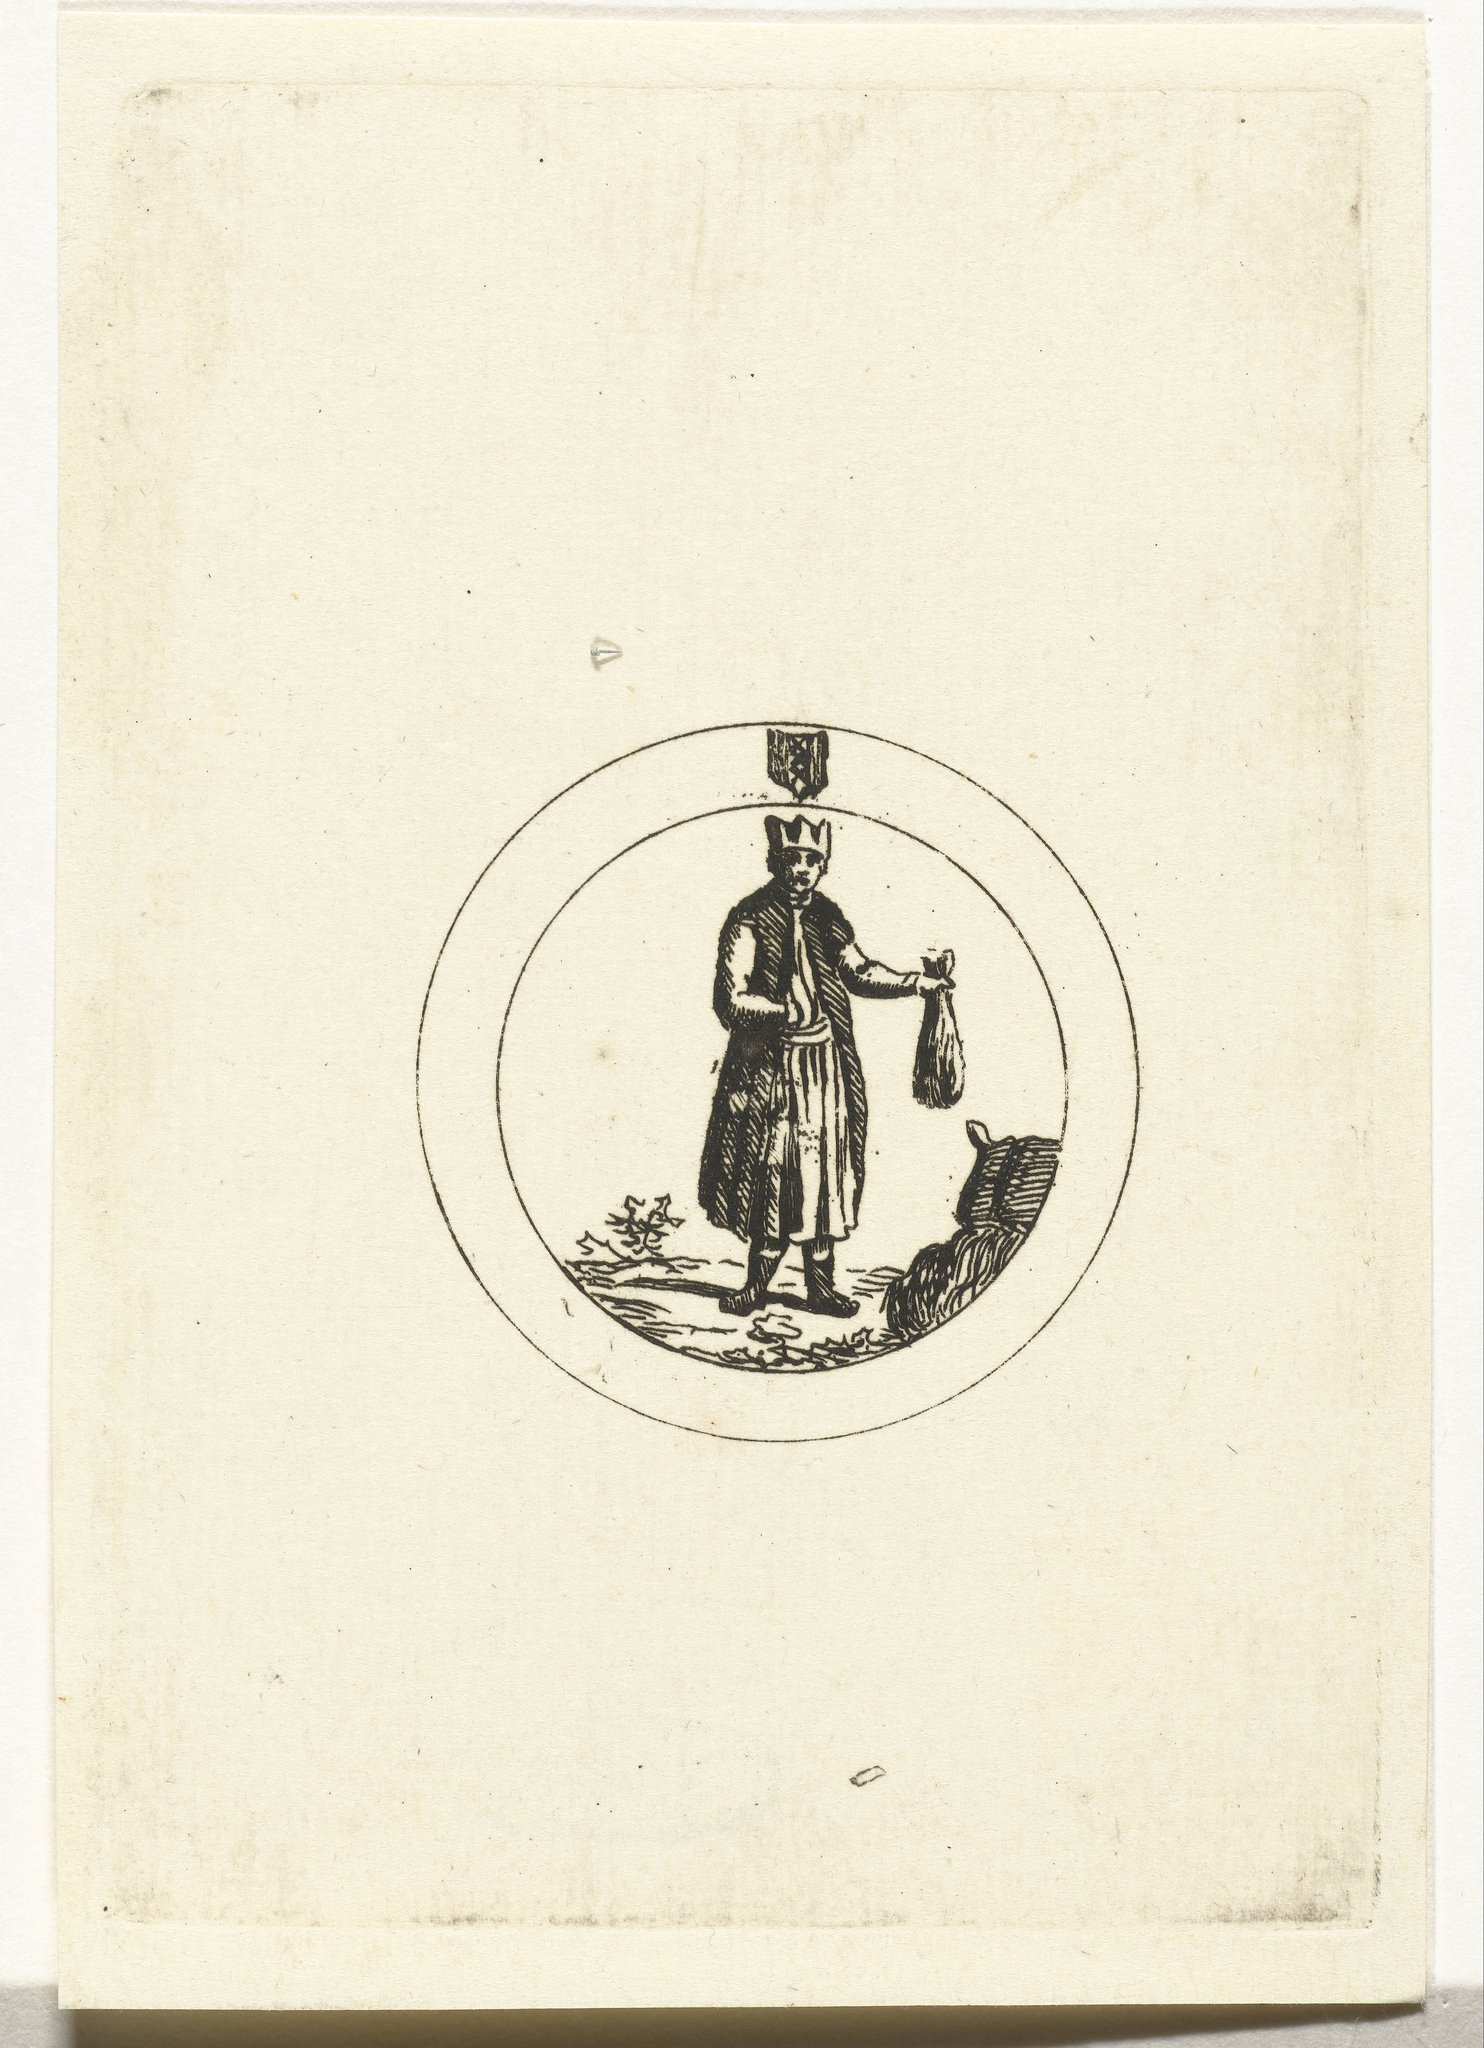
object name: print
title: Staande figuur in een cirkel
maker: anthonie van den bos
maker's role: draughtsman, print maker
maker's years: 1763-1838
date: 1778-1838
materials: paper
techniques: etching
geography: netherlands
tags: trade mark, trade token, trade sign, trade card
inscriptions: collector's mark: Lugt 2228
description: Koopmansmerk(?): een staande figuur met kroon op het hoofd, de rechterhand in de borst gestoken, in de andere hand houdt hij een tabaksblad (?). Rechts ligt een baal op de grond. Boven de figuur het Amsterdamse stadswapen.